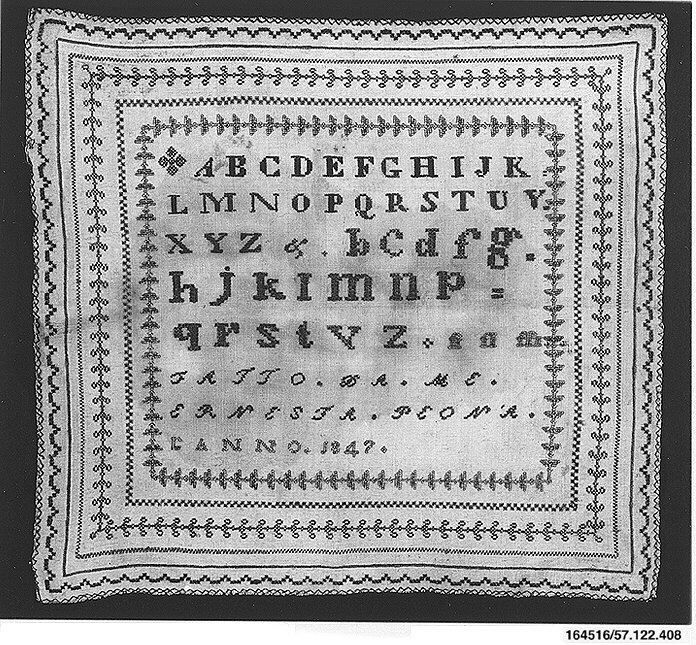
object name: sampler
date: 1847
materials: linen, silk